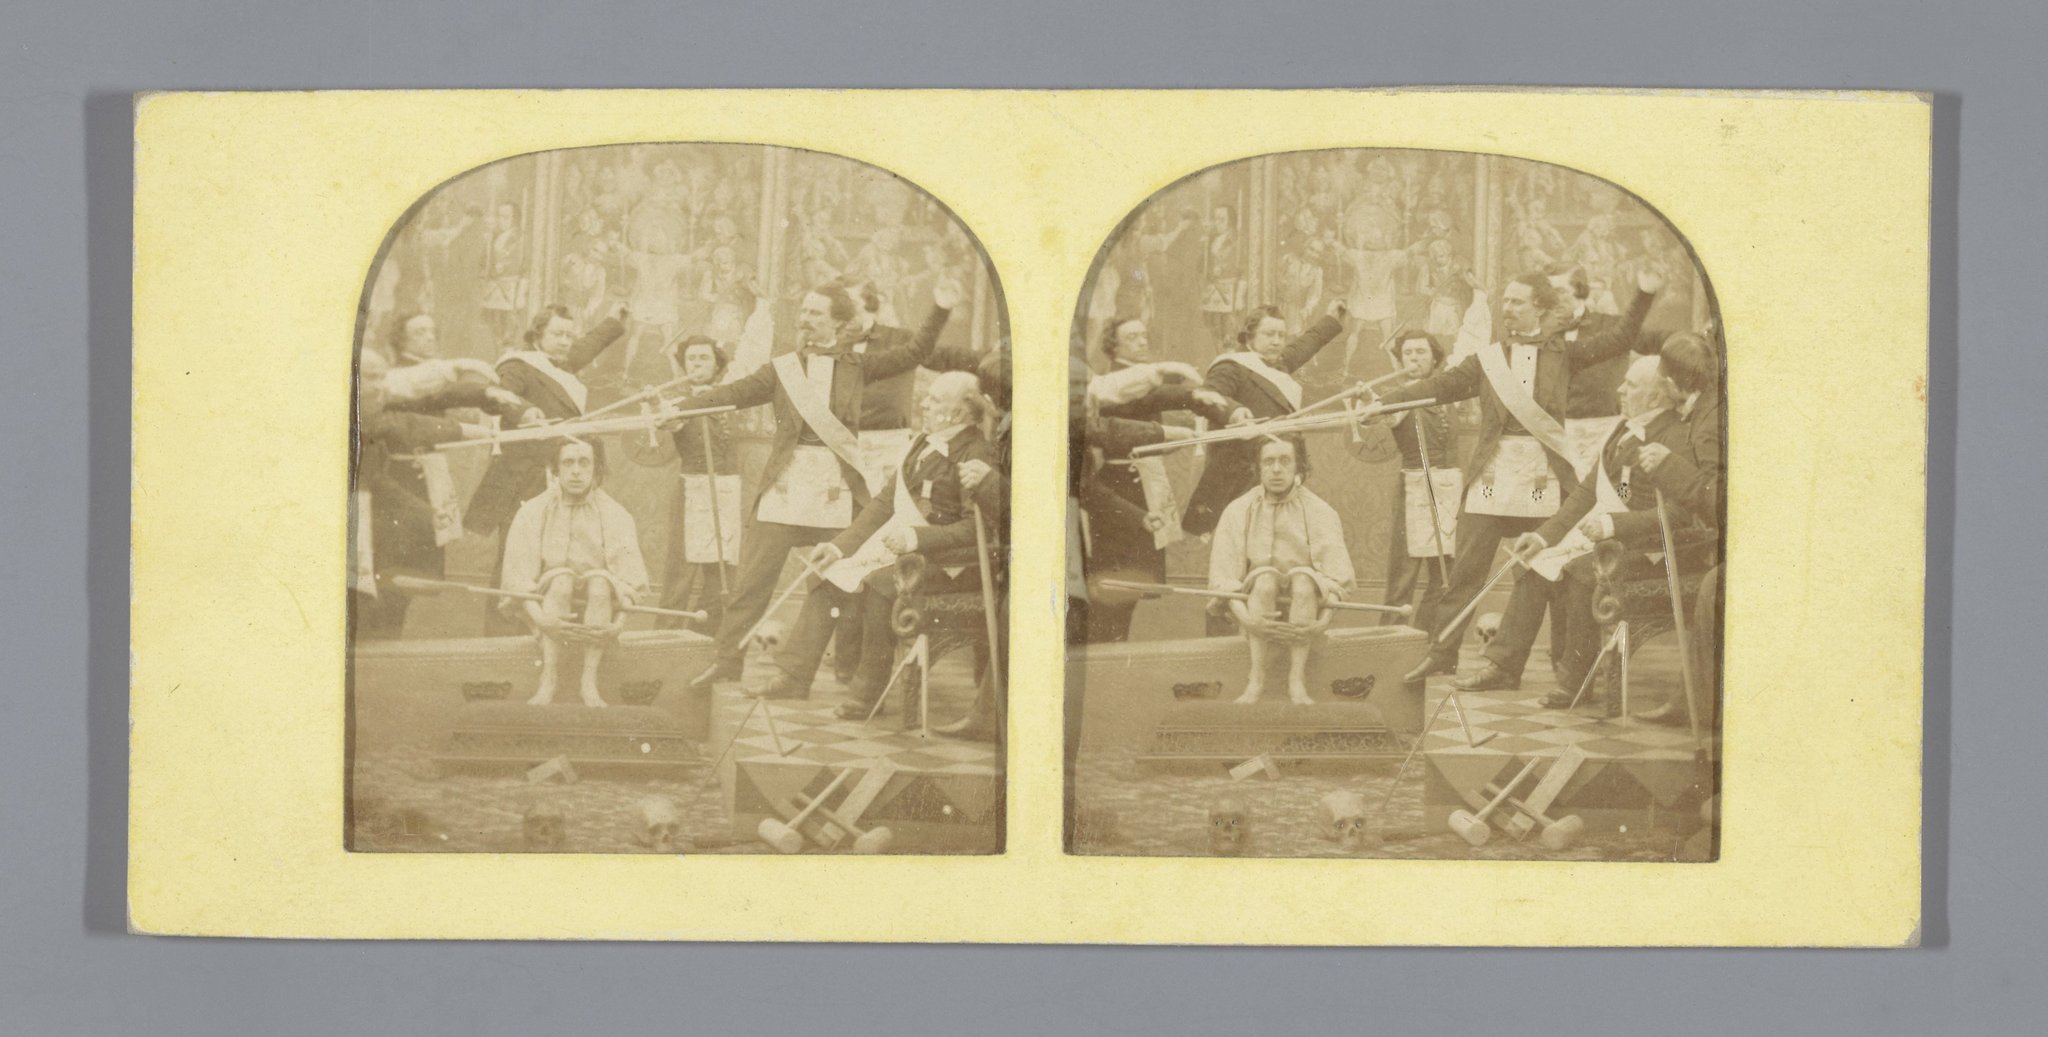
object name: tissue stereograph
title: Vrijmetselaarsritueel: mannen kruisen zwaarden boven hoofd andere man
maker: alfred silvester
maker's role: fotograaf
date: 1855-1864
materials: cardboard, paper, photographic support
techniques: albumen print, cutting, hand coloring, perforating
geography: london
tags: ritual objects and ritual means ~ freemasonry